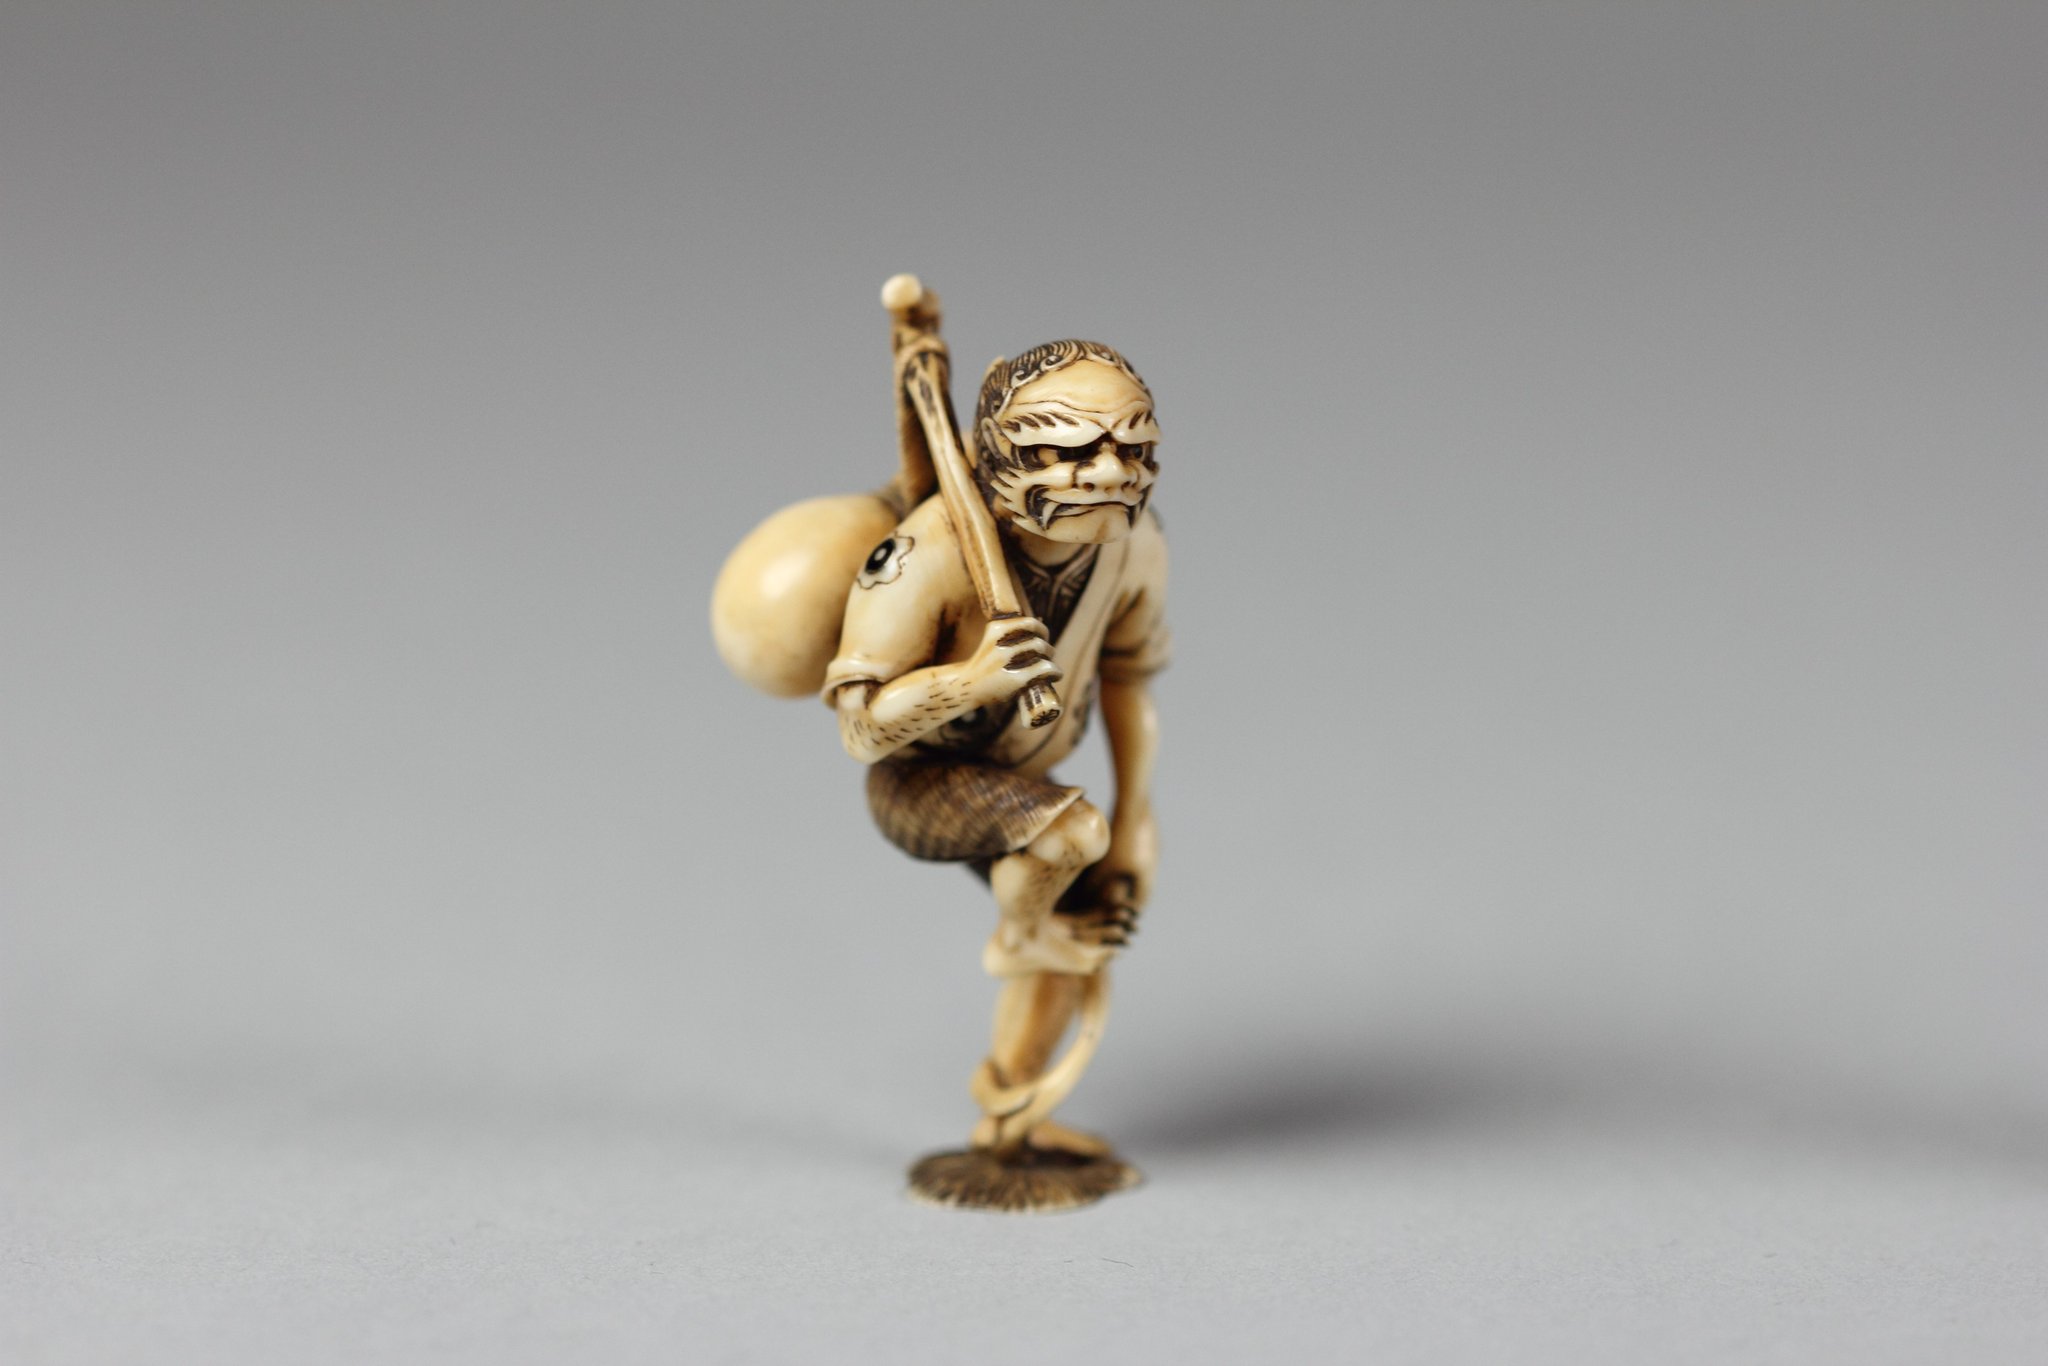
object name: netsuke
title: Netsuke of a Demon Carrying a Gourd on His Back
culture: japanese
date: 1801-1900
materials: ivory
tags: demons,gourds